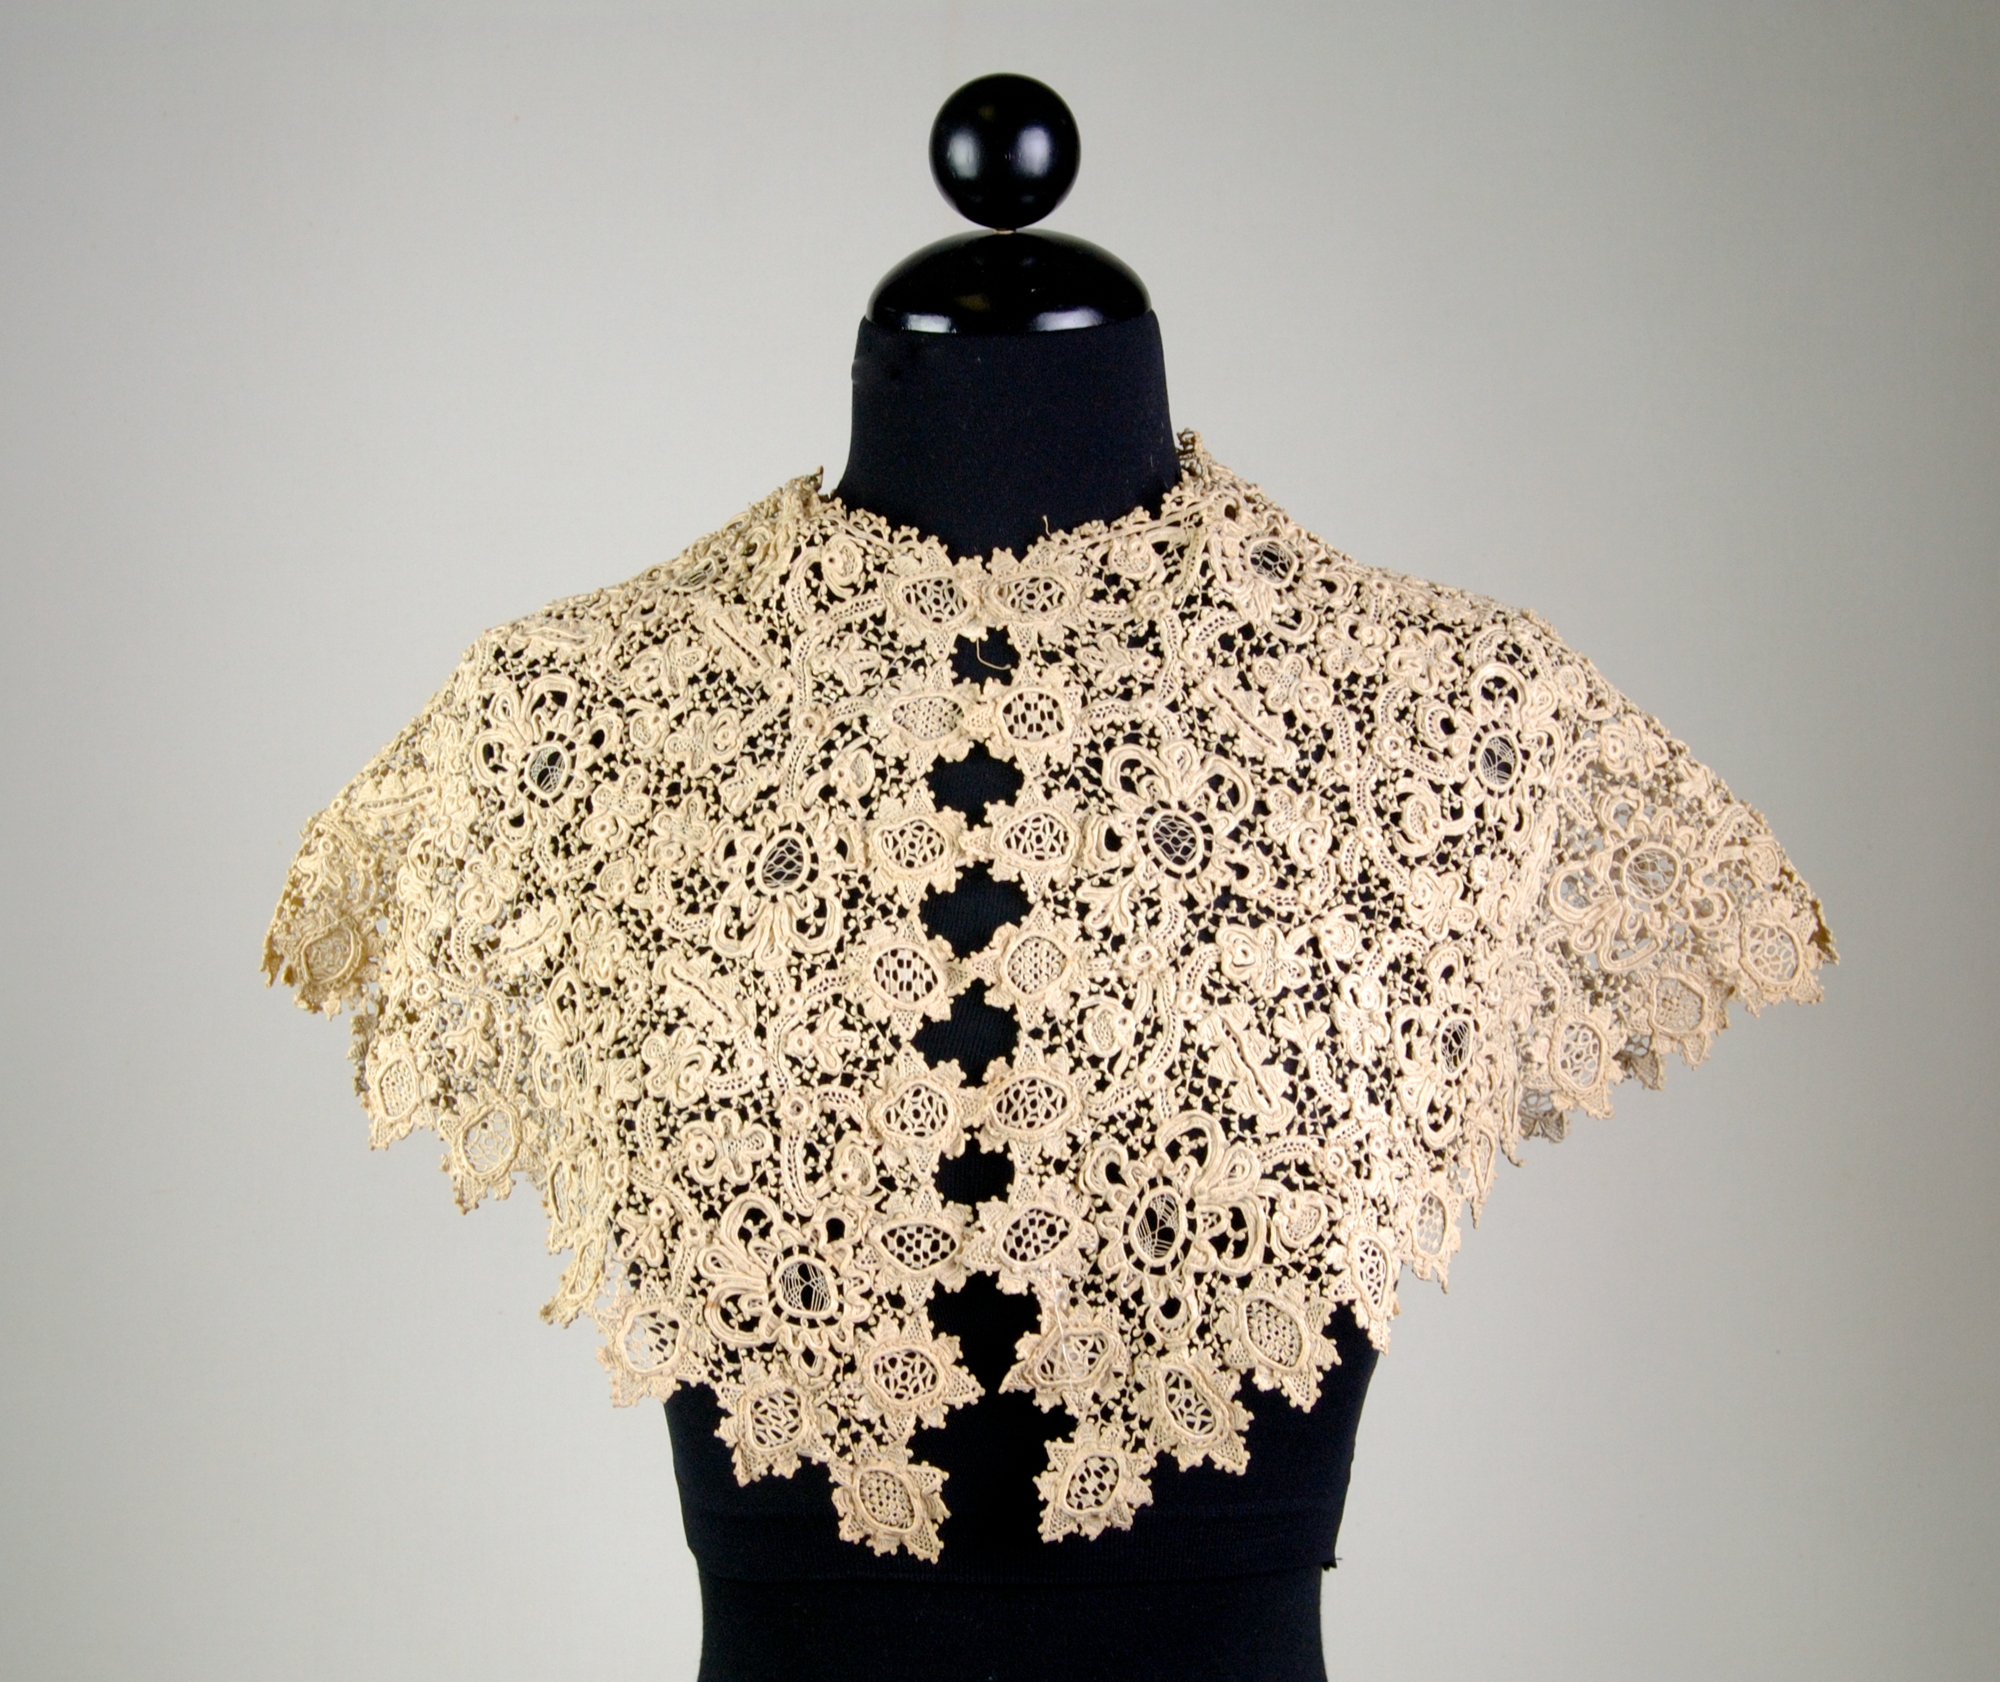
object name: pelerine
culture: irish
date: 1895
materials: cotton